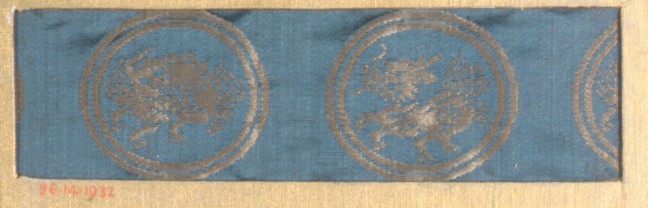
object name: piece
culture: japanese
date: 1701-1900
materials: silk